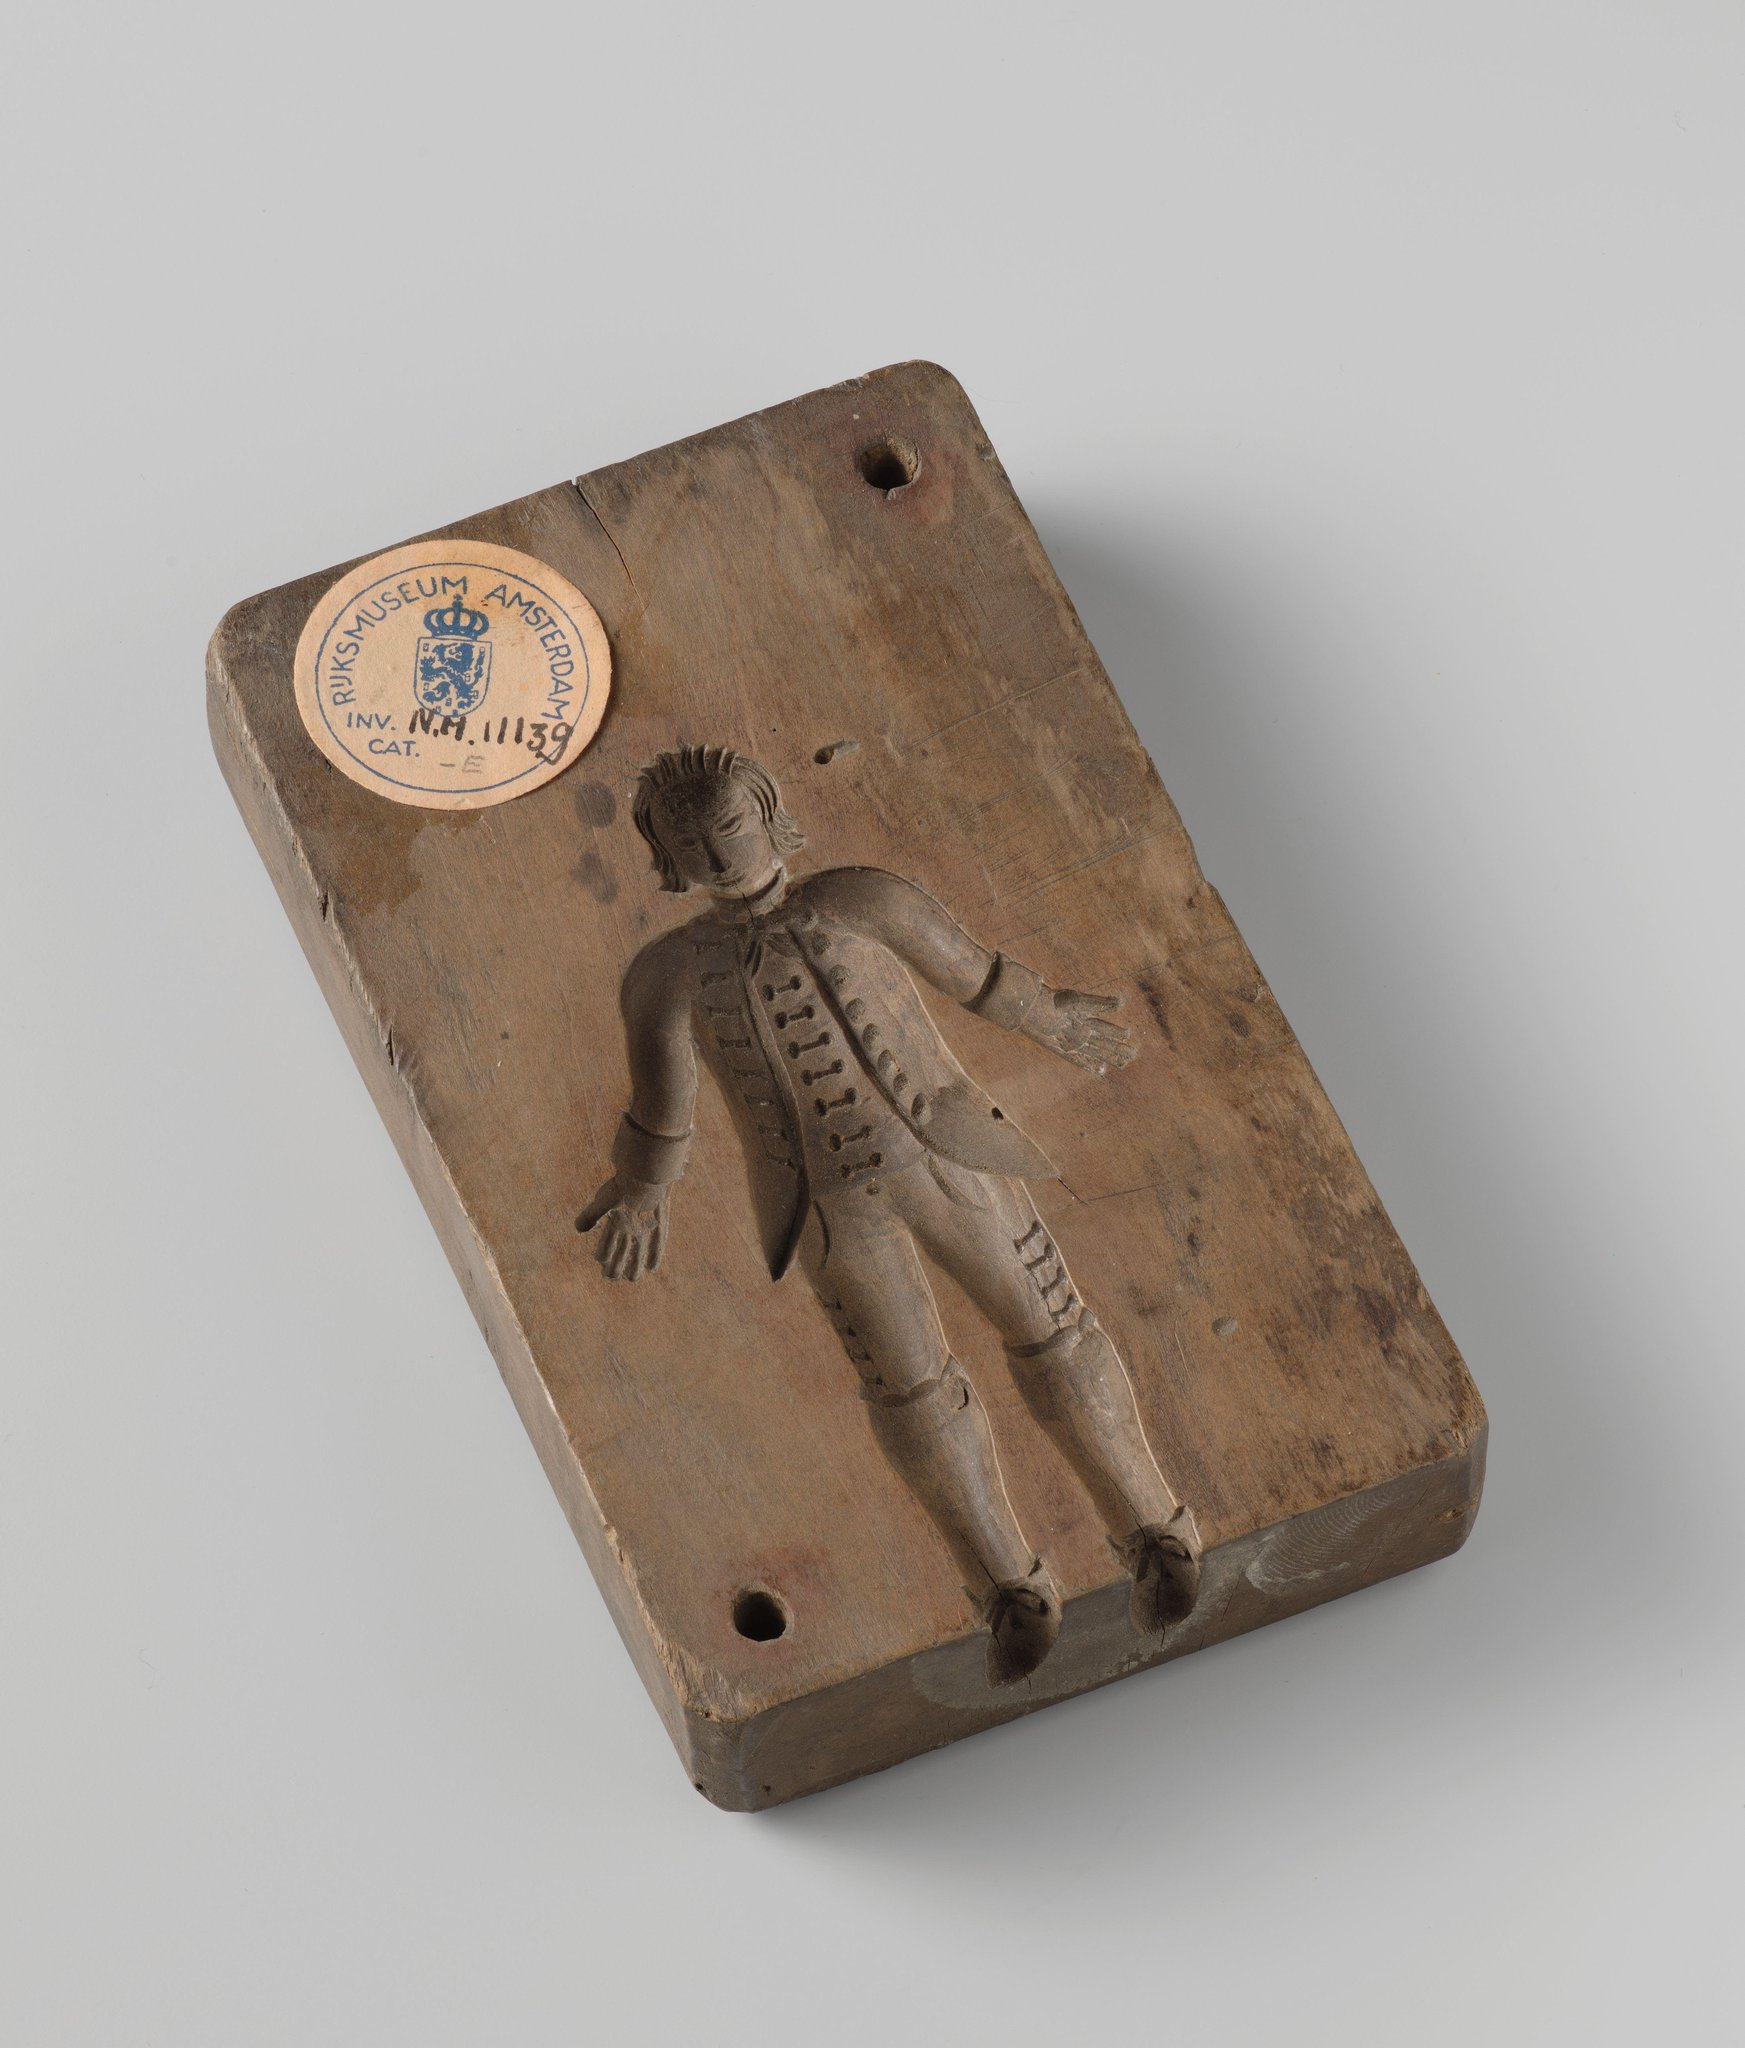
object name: suikergoedvorm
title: Suikergoedvorm van perenhout in de vorm van een man in negentiende-eeuws kostuum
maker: Anonymous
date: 1800-1900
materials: wood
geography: netherlands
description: Suikergoedvorm van perenhouthout in de vorm van een man in negentiende-eeuws kostuum.